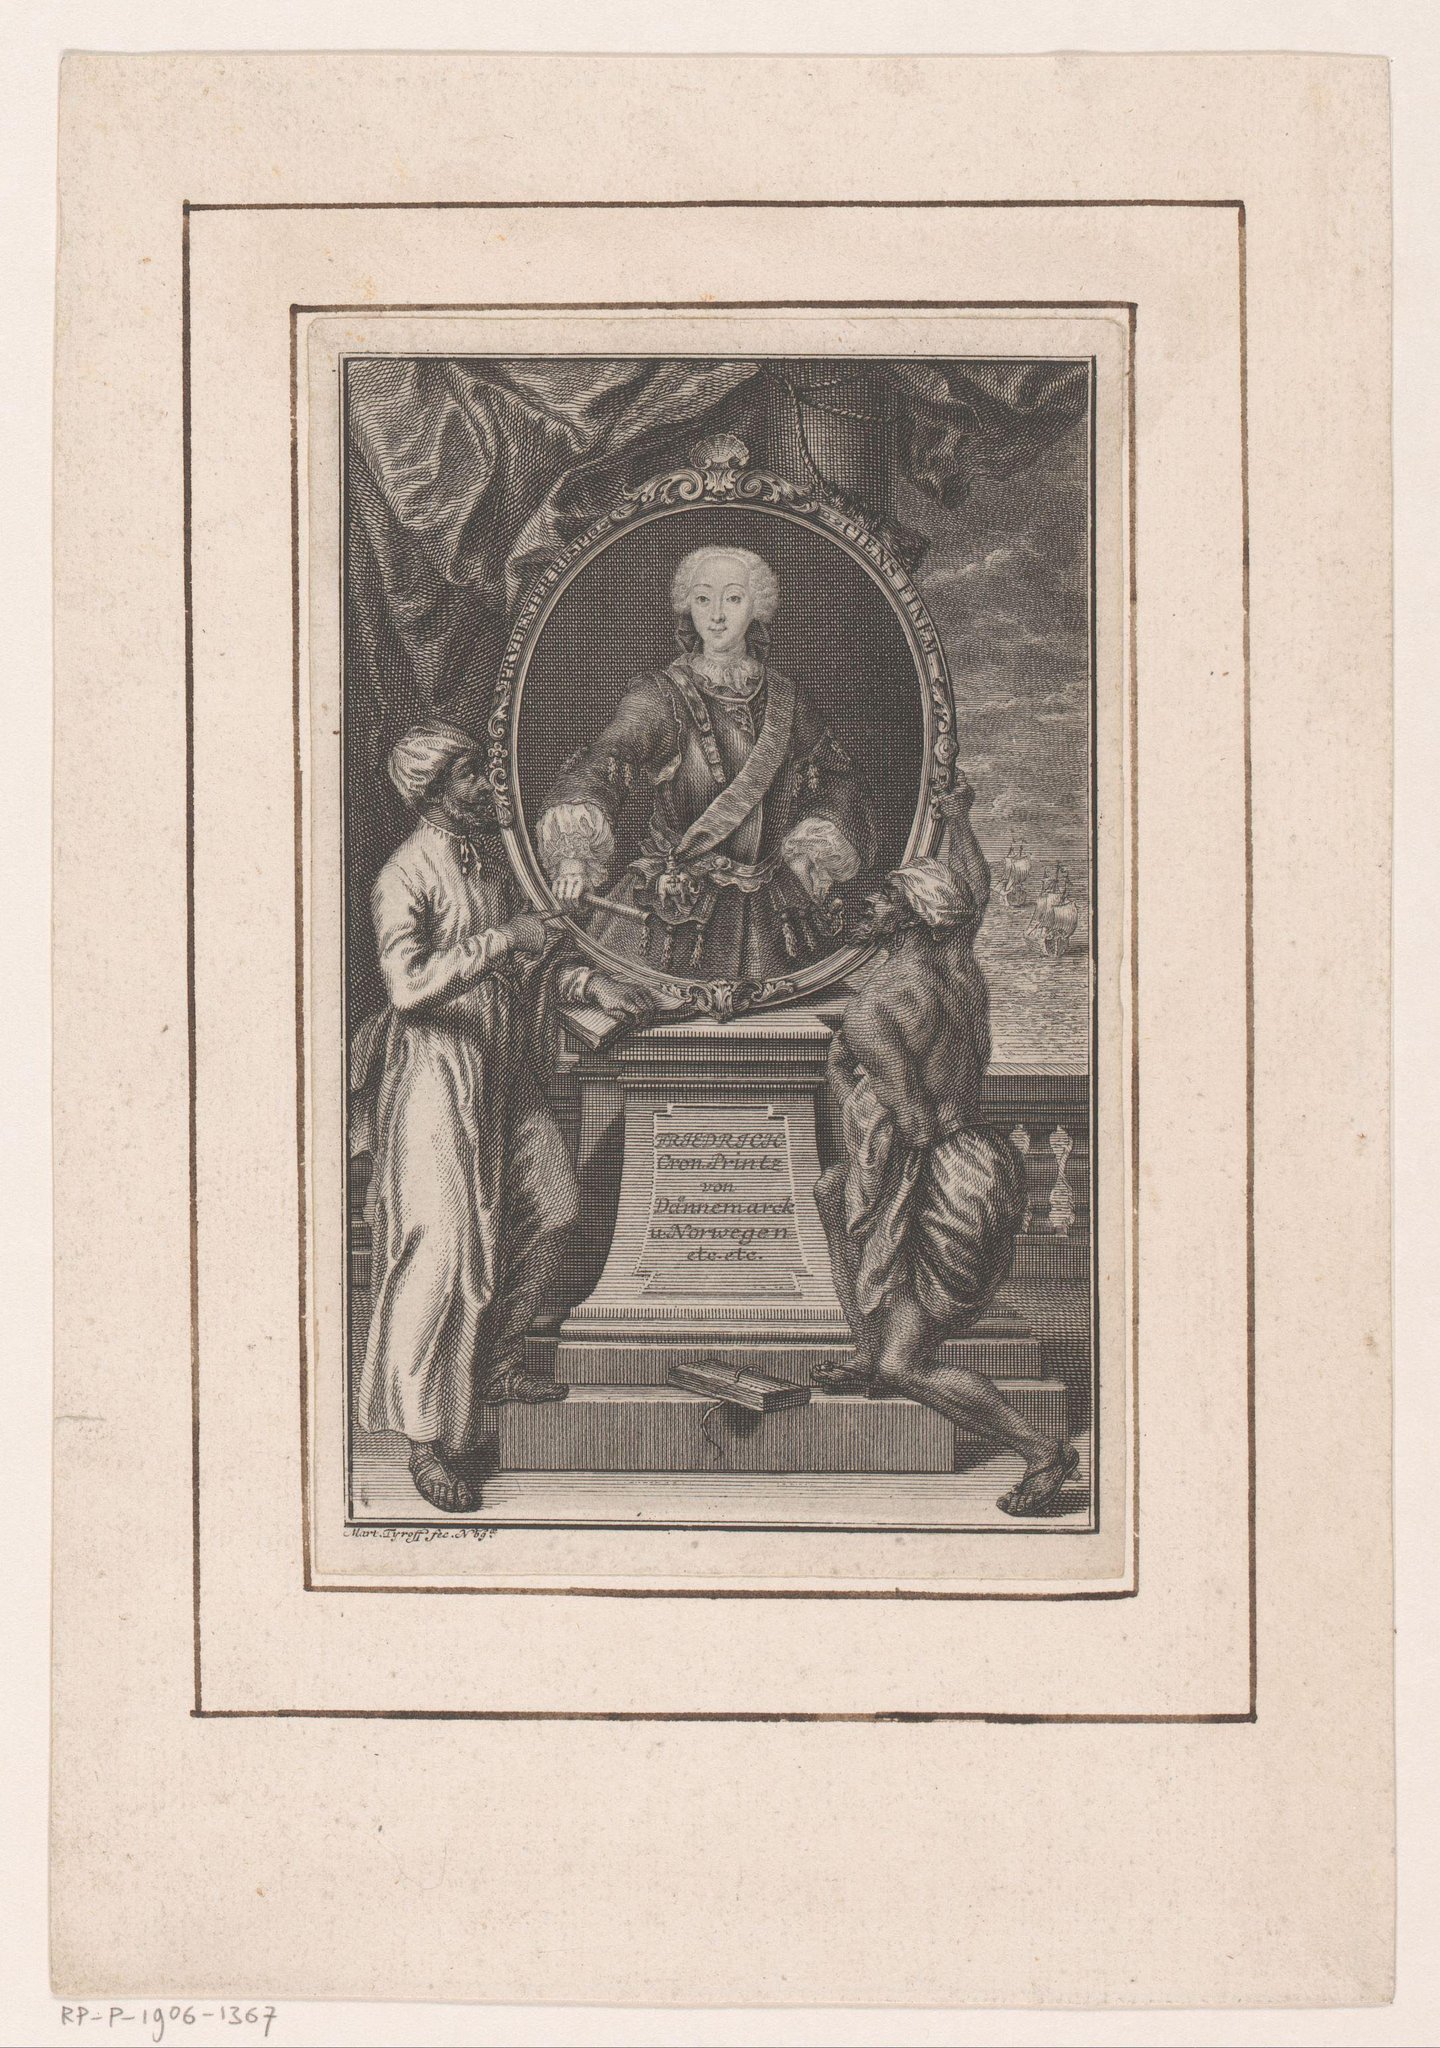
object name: print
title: Portret van Frederik V, koning van Denemarken en Noorwegen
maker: martin tyroff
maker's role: print maker, publisher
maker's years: 1704-1779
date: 1714-1746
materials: paper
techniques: etching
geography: nuremberg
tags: copenhagen (city), historical persons, baton of general, knighthood order (elephant)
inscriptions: collector's mark: Lugt 2228